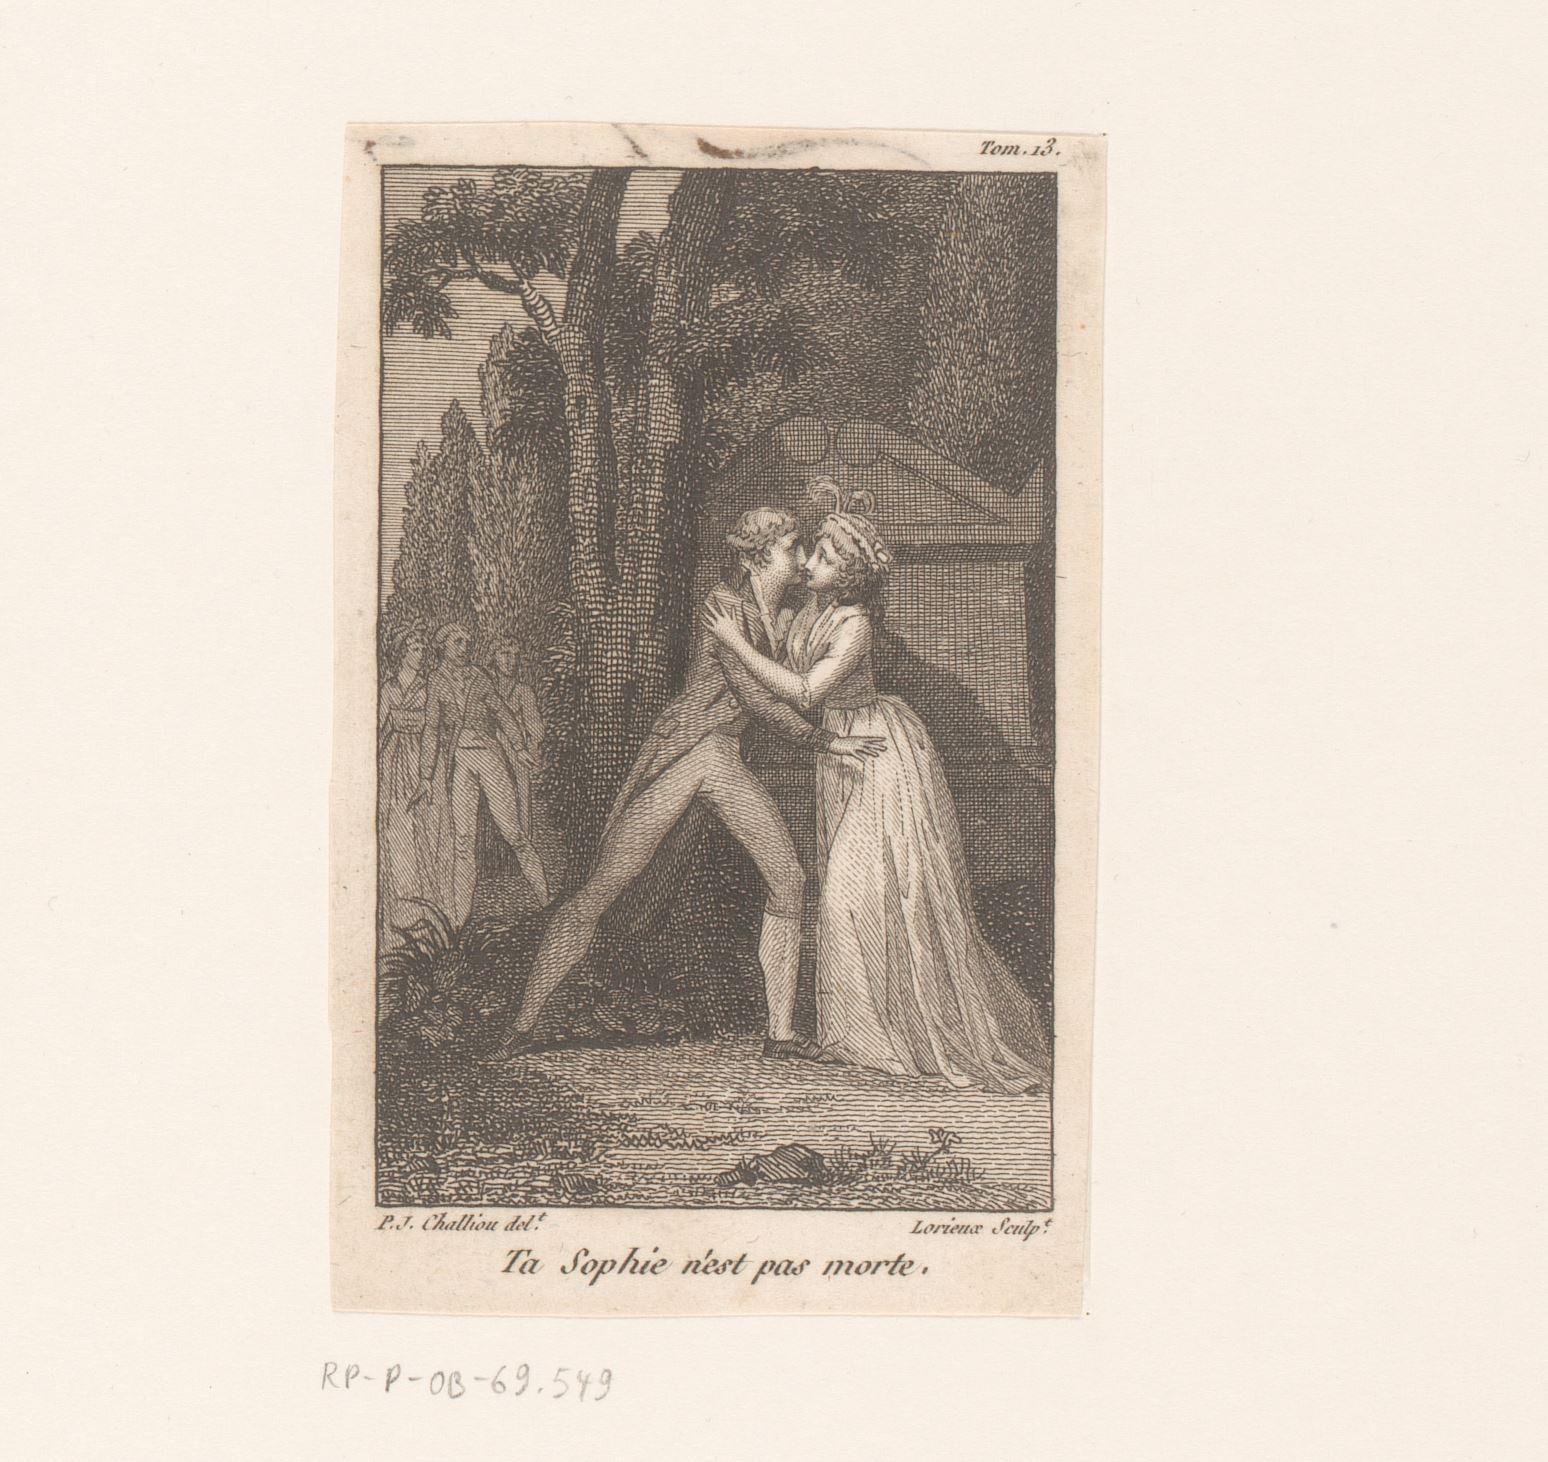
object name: book illustration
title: Man en vrouw in omhelzing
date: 1791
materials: paper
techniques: engraving, etching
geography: france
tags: (lovers) embracing each other, 'symplegma'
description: Mogelijk prent uit: Louvet de Couvray, Jean-Baptiste. Les amours et les galanteries du chevalier De Faublas. Parijs: M. Louvet de Couvray, 1791, dl. 13 of een later geïllustreerde editie.